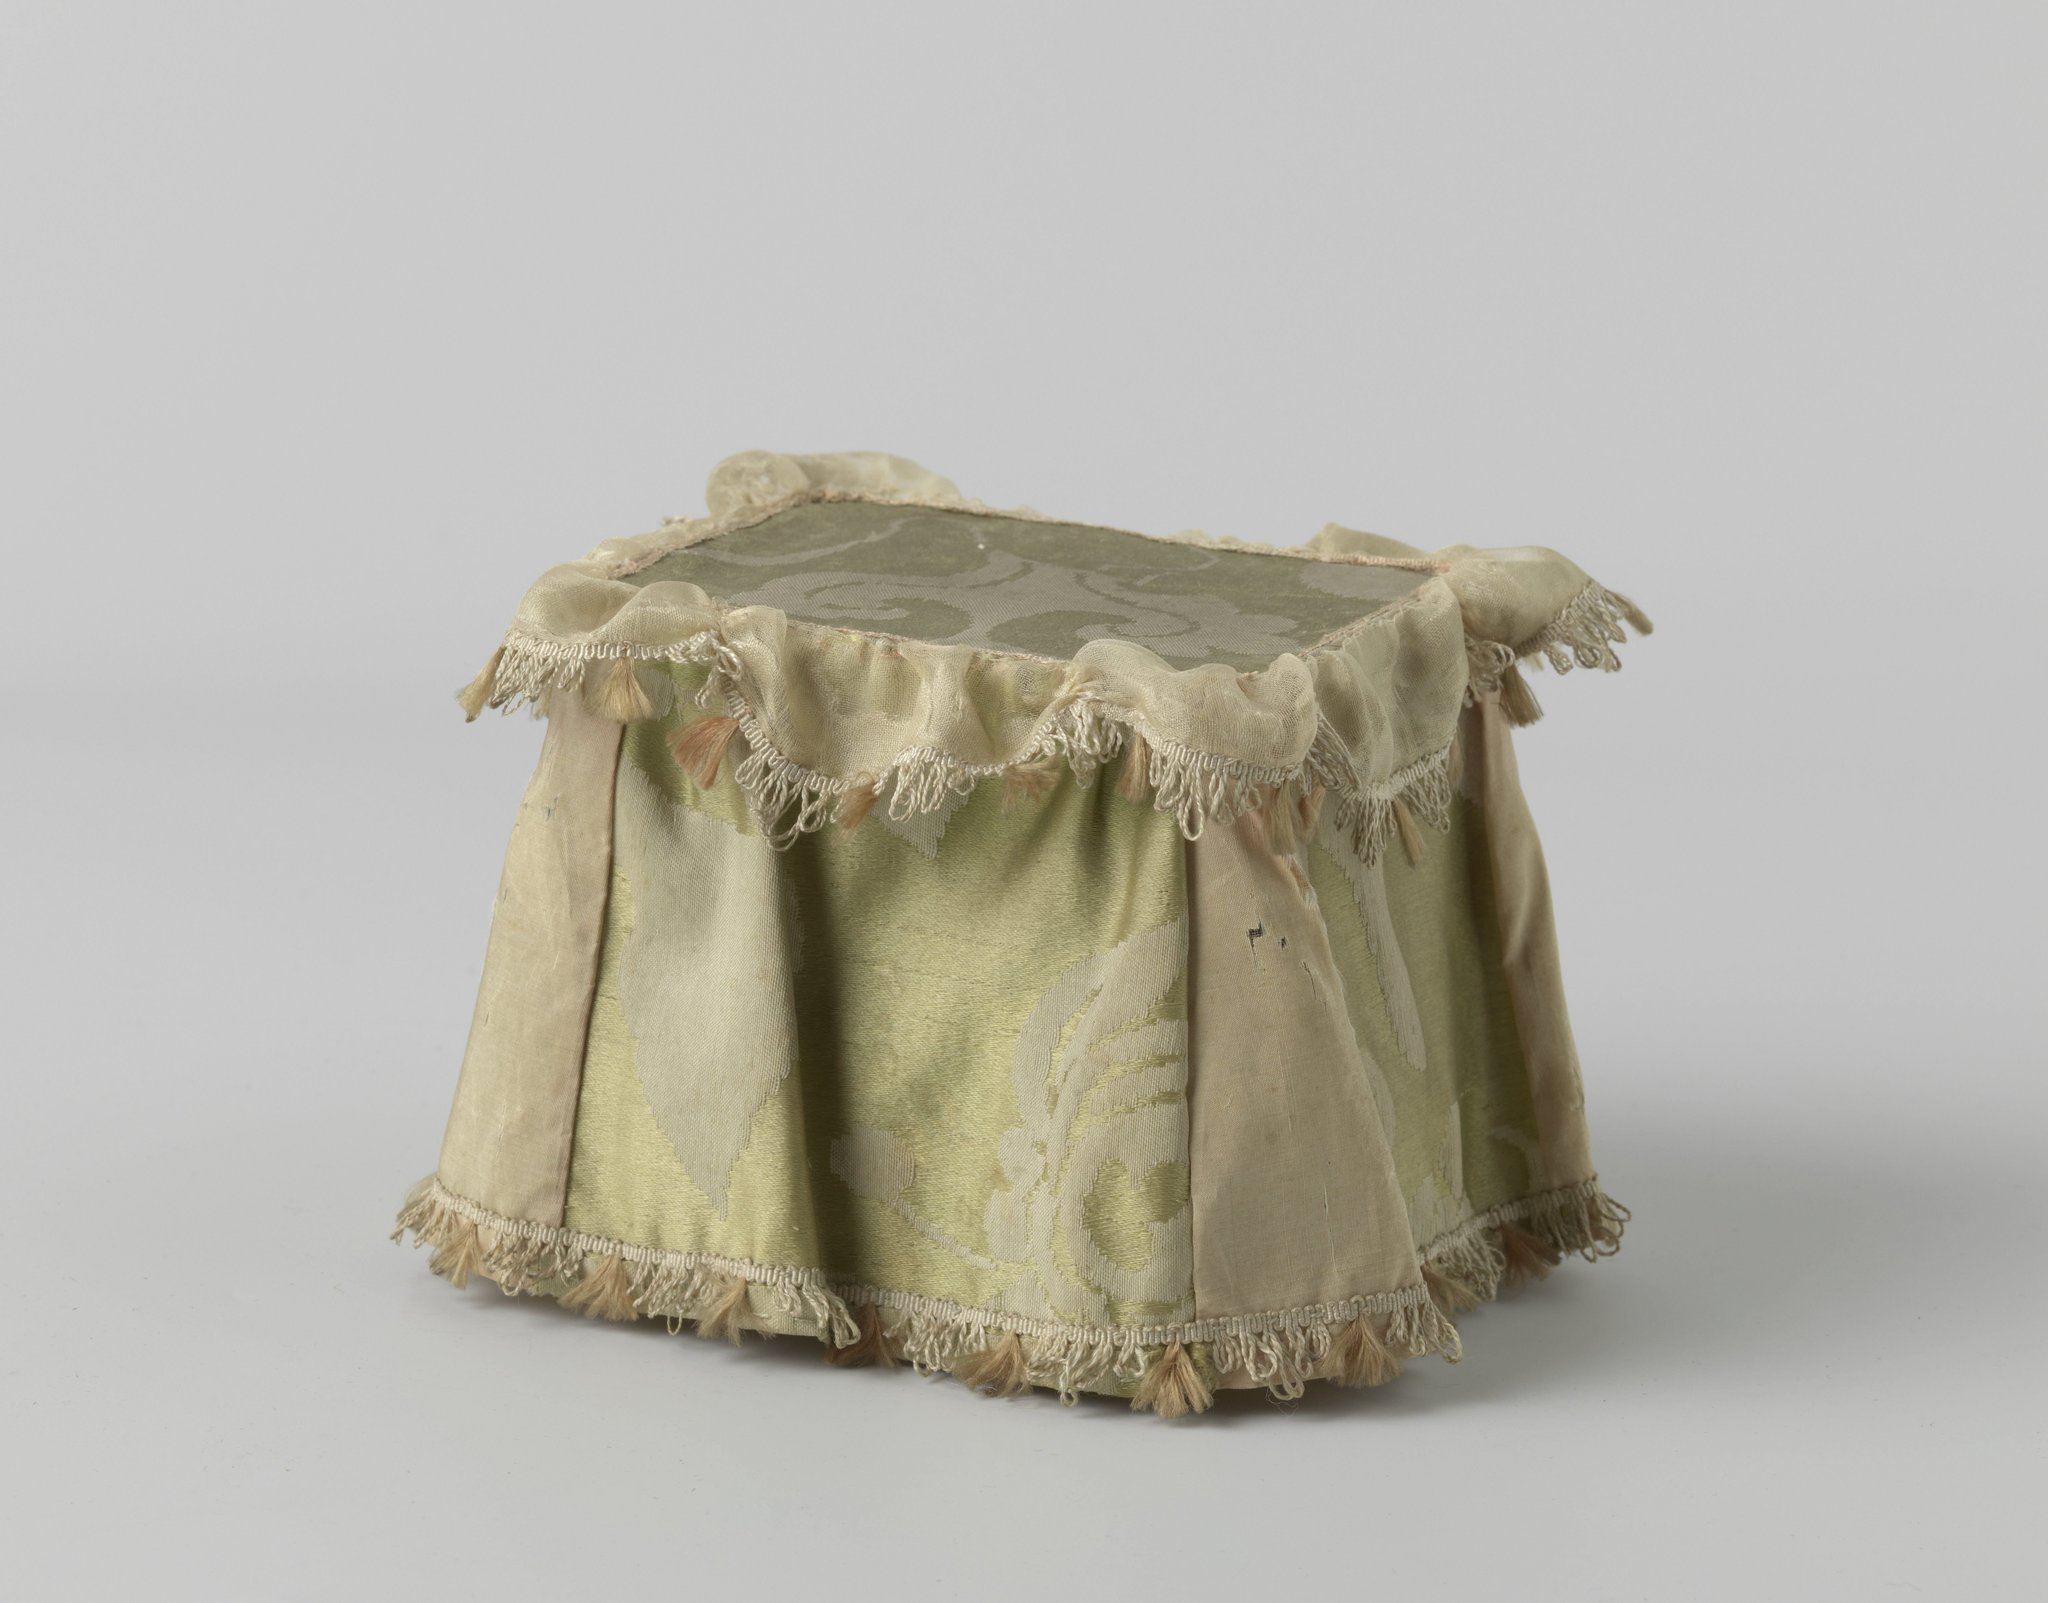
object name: vuurmand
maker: Anonymous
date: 1700-1799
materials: leather, silk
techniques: damask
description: Vuurmand met kleed van (oorspronkelijk) groen damast. Met kussen (BK-NM-10979-1).